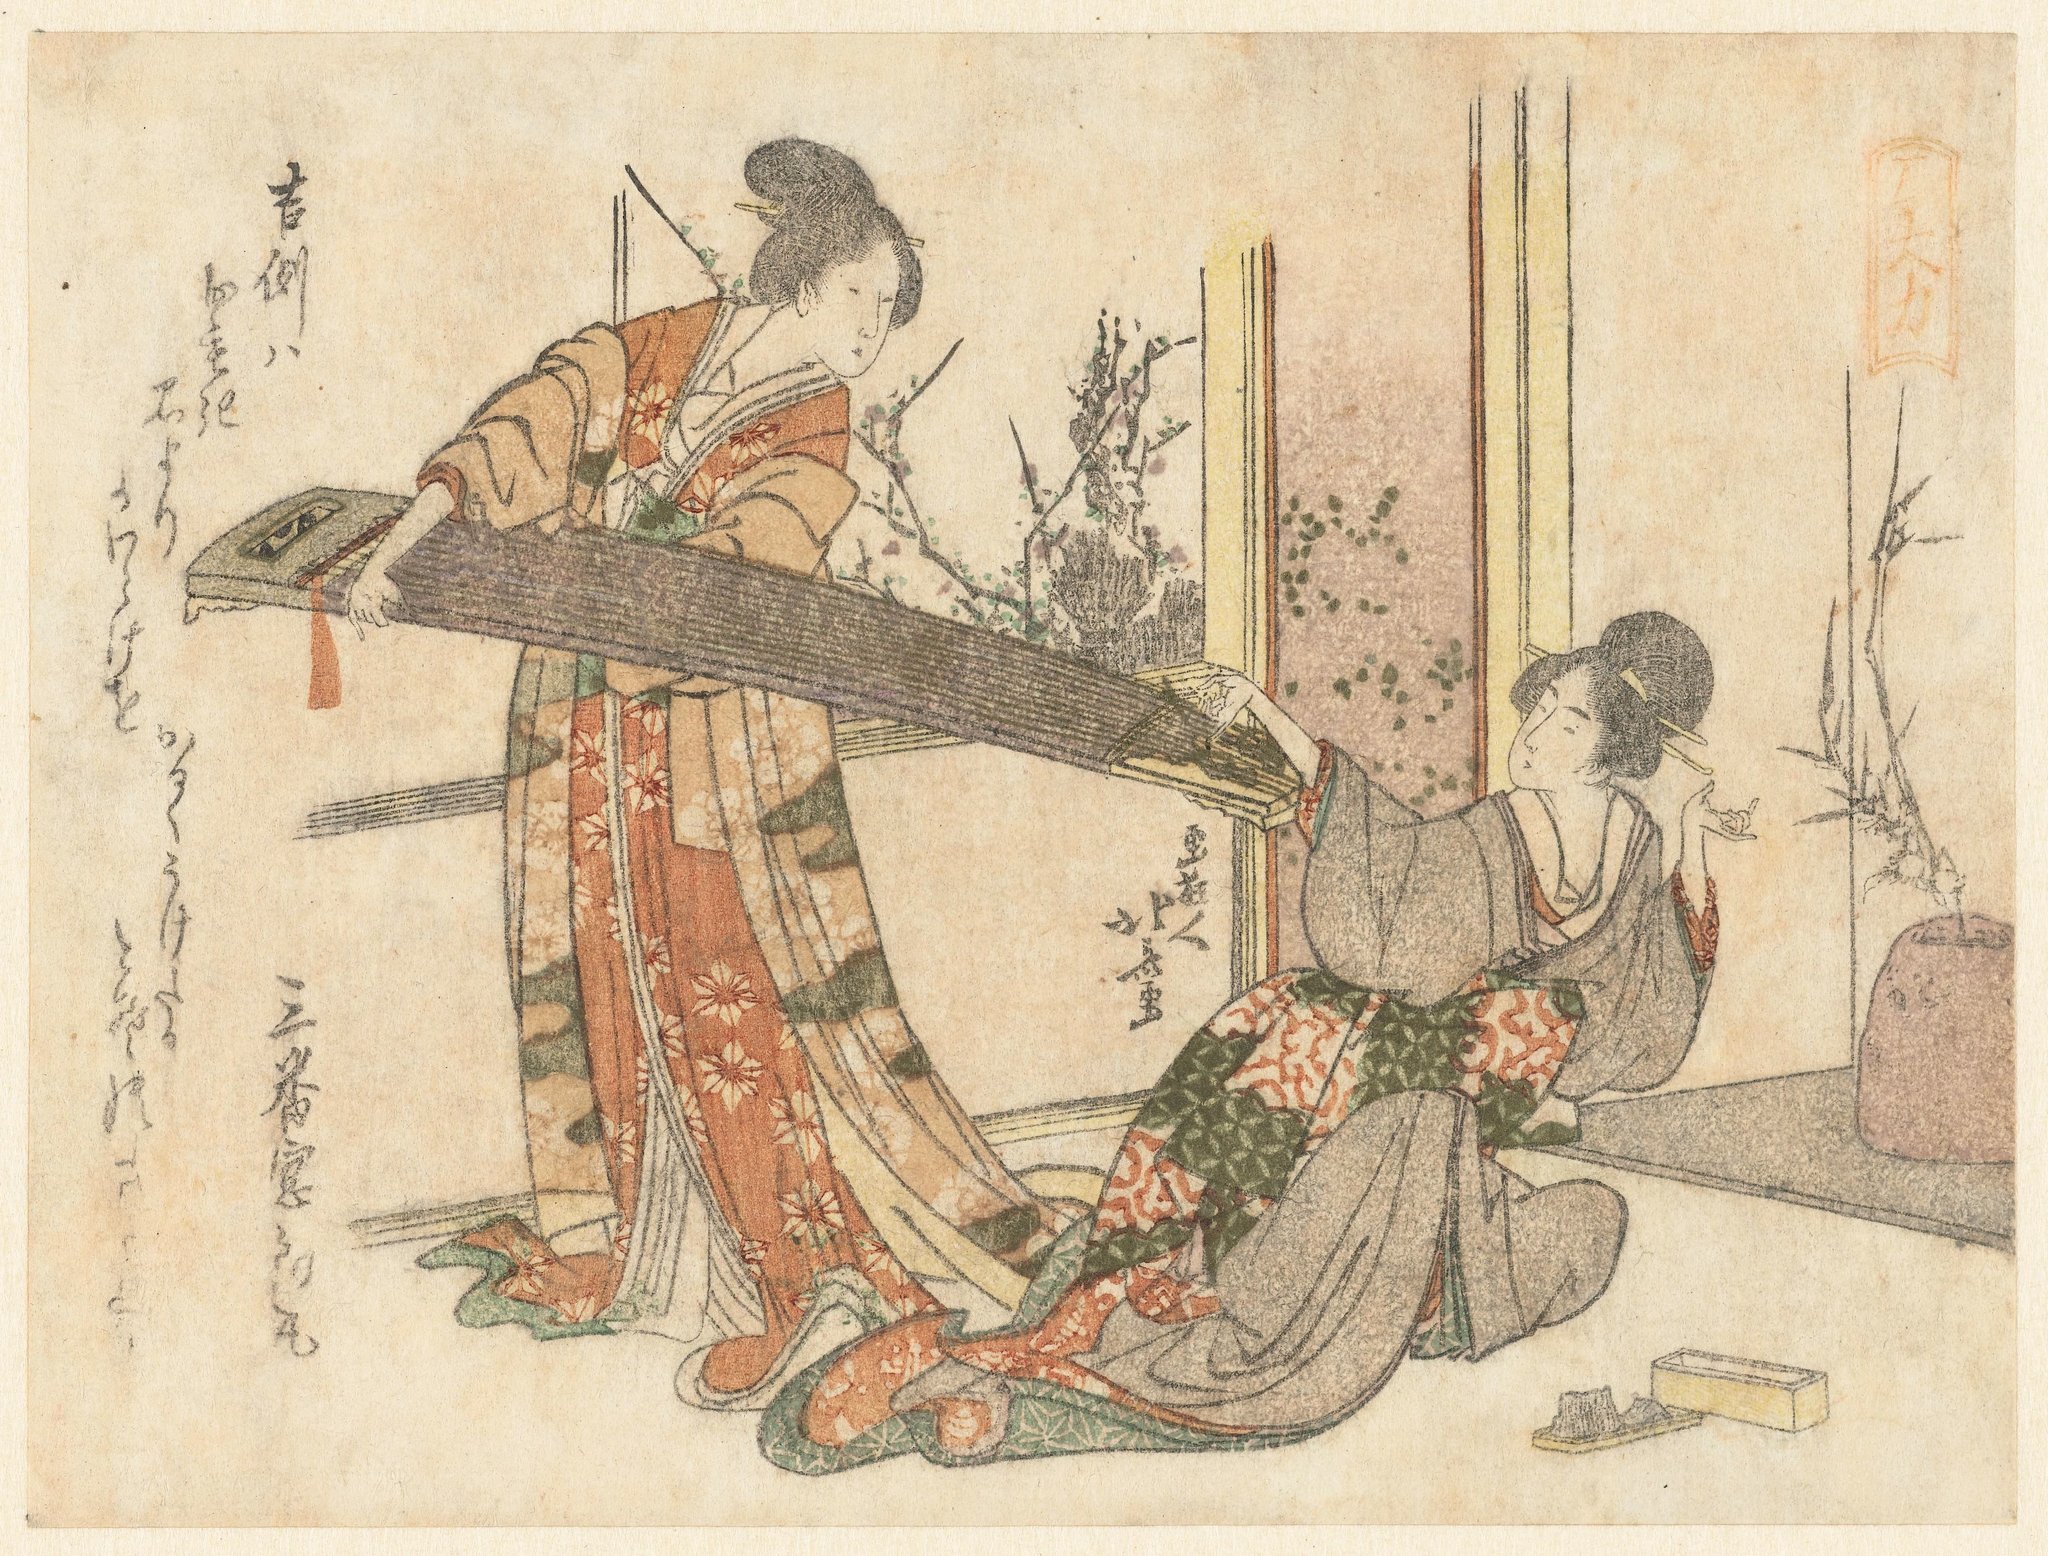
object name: print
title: Two Women With a Koto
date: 1800-1805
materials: paper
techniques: blind stamped, woodcut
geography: japan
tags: other string instruments (plucked)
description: Een surimono is een luxe uitgevoerde prent waarop beeld met één of meerdere gedichten gecombineerd is. Bij het drukken van een surimono werd vaak gebruik gemaakt van dikker papier, blinddruk en metaal pigmenten, zoals koper- en zilverpoeder. De prenten werden vaak in opdracht van dichters gemaakt en als exclusief geschenk aan vrienden en relaties gegeven.